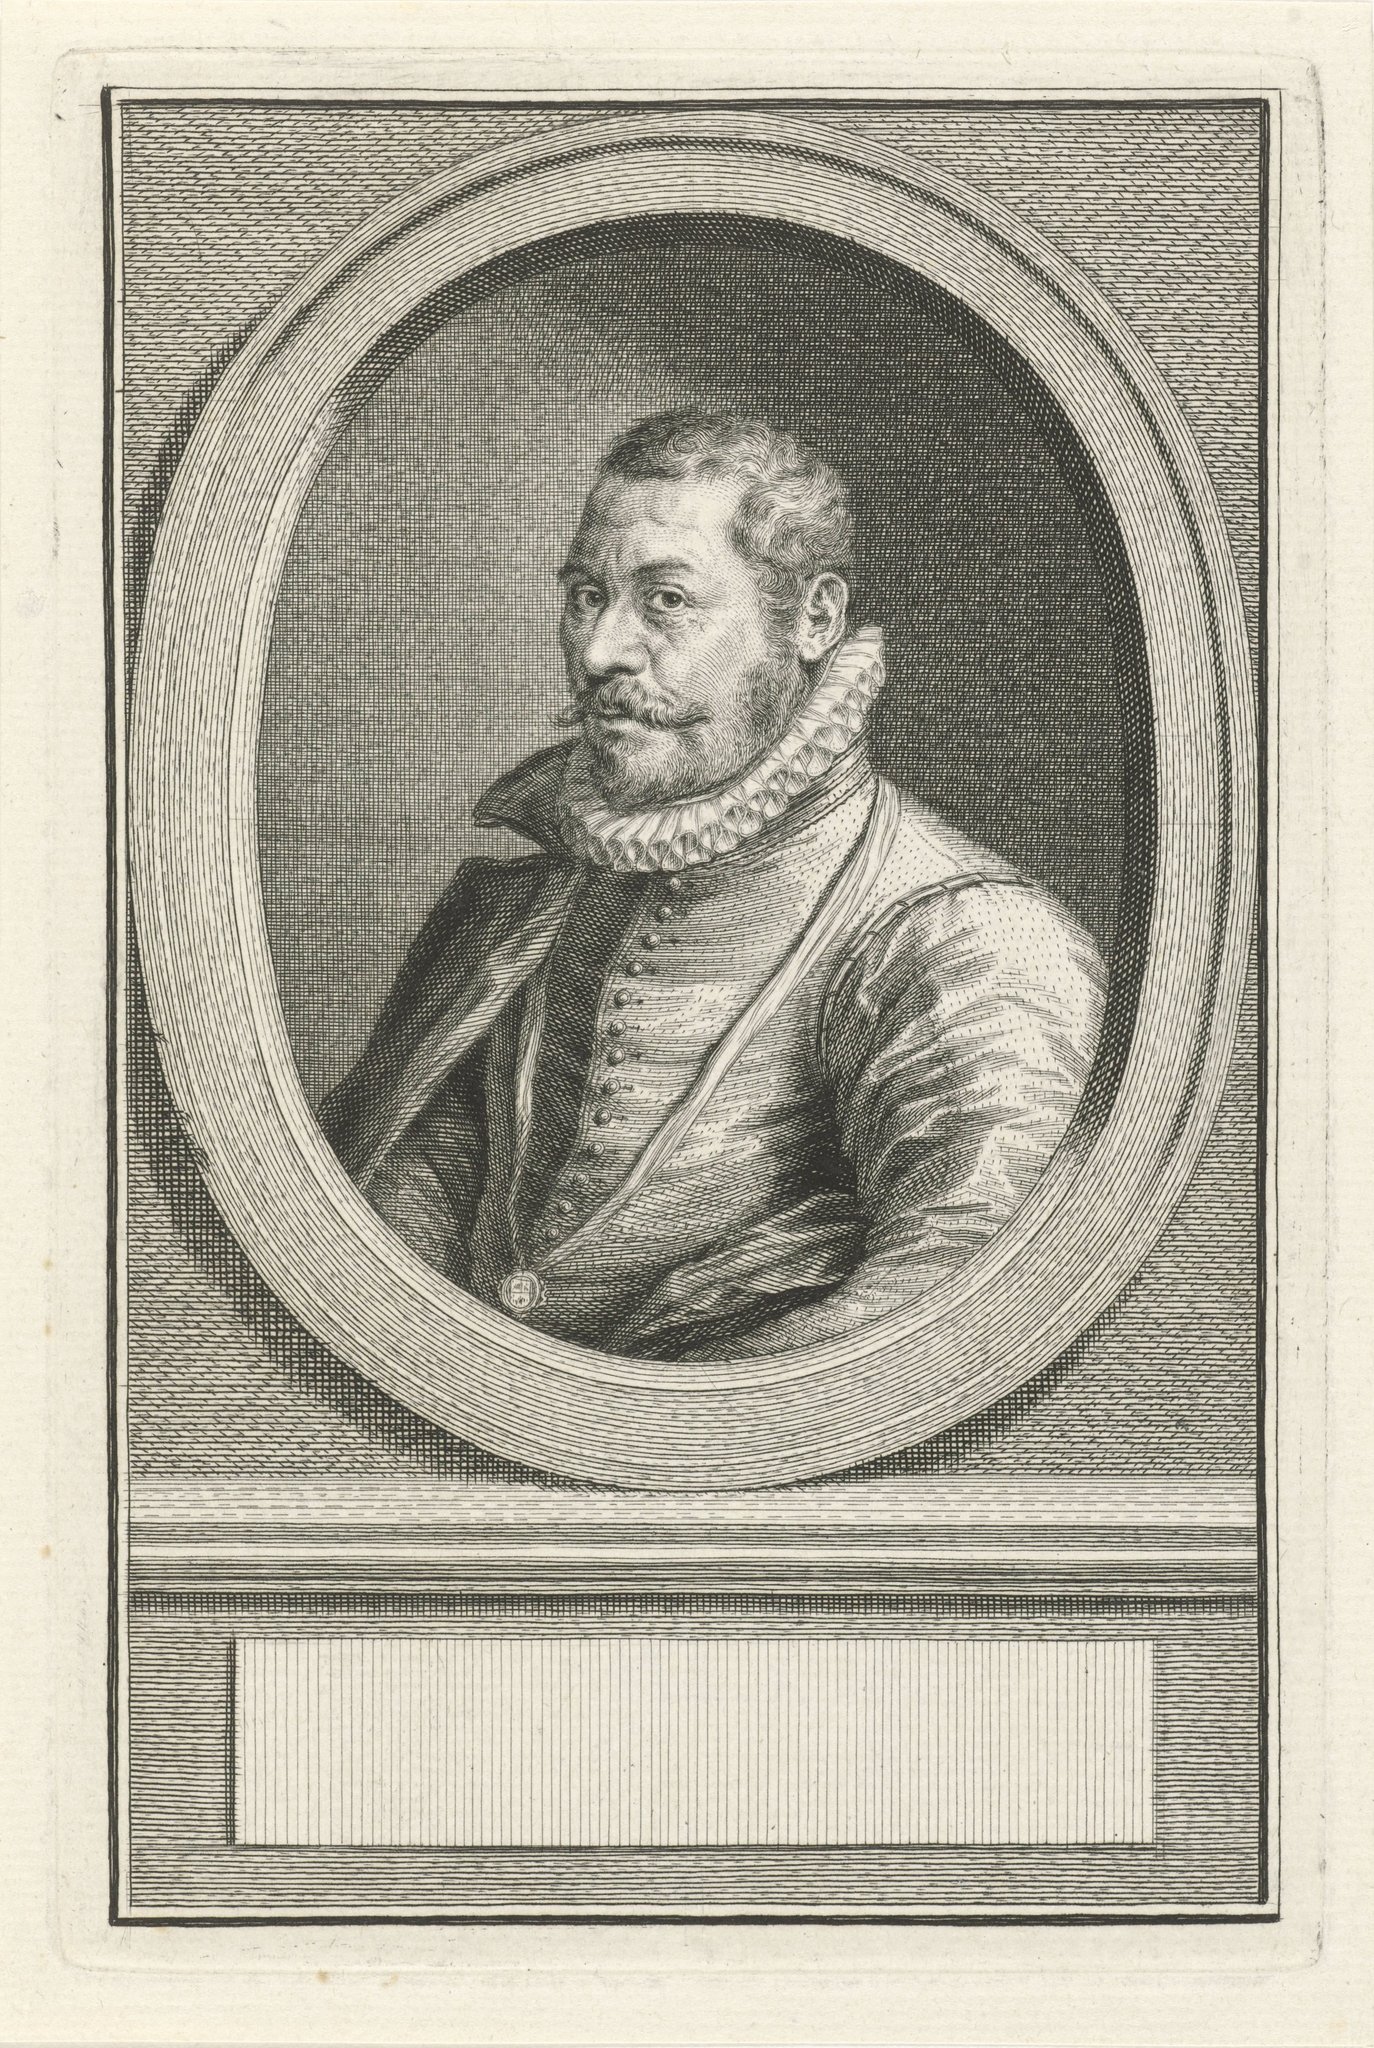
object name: print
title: Portret van François Maelson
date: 1747-1759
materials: paper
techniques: engraving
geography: amsterdam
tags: enkhuizen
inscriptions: collector's mark: Lugt 240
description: Proefdruk van de prent gebruikt in: Jan Wagenaar, Vaderlandsche historie, vervattende de geschiedenissen der nu Vereenigde Nederlanden, inzonderheid die van Holland (...), 21 delen. Amsterdam, Isaak Tirion, 1749-59.